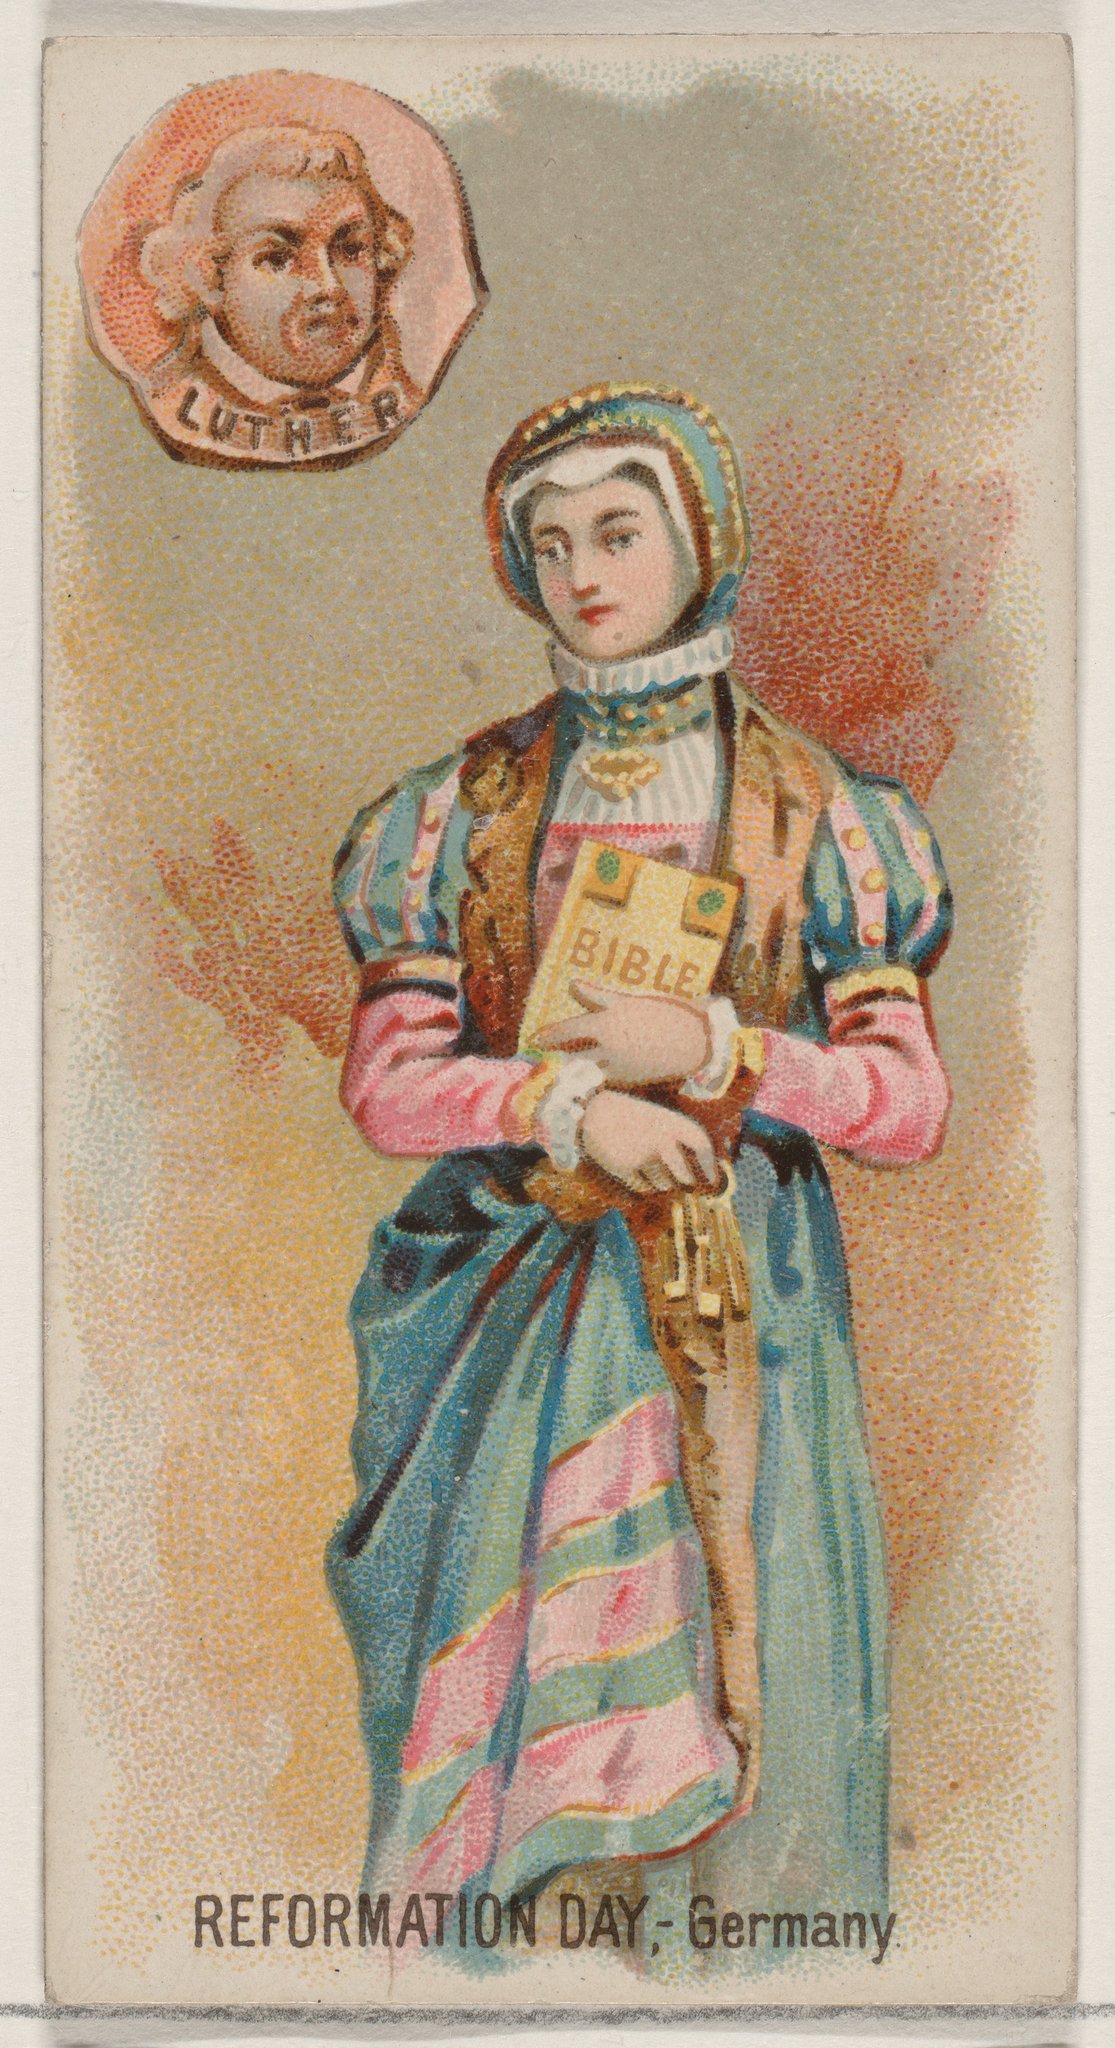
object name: print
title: Reformation Day, Germany, from the Holidays series (N80) for Duke brand cigarettes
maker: w. duke, sons & co.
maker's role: publisher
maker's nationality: american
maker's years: 1870-1920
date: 1890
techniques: color lithograph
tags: women